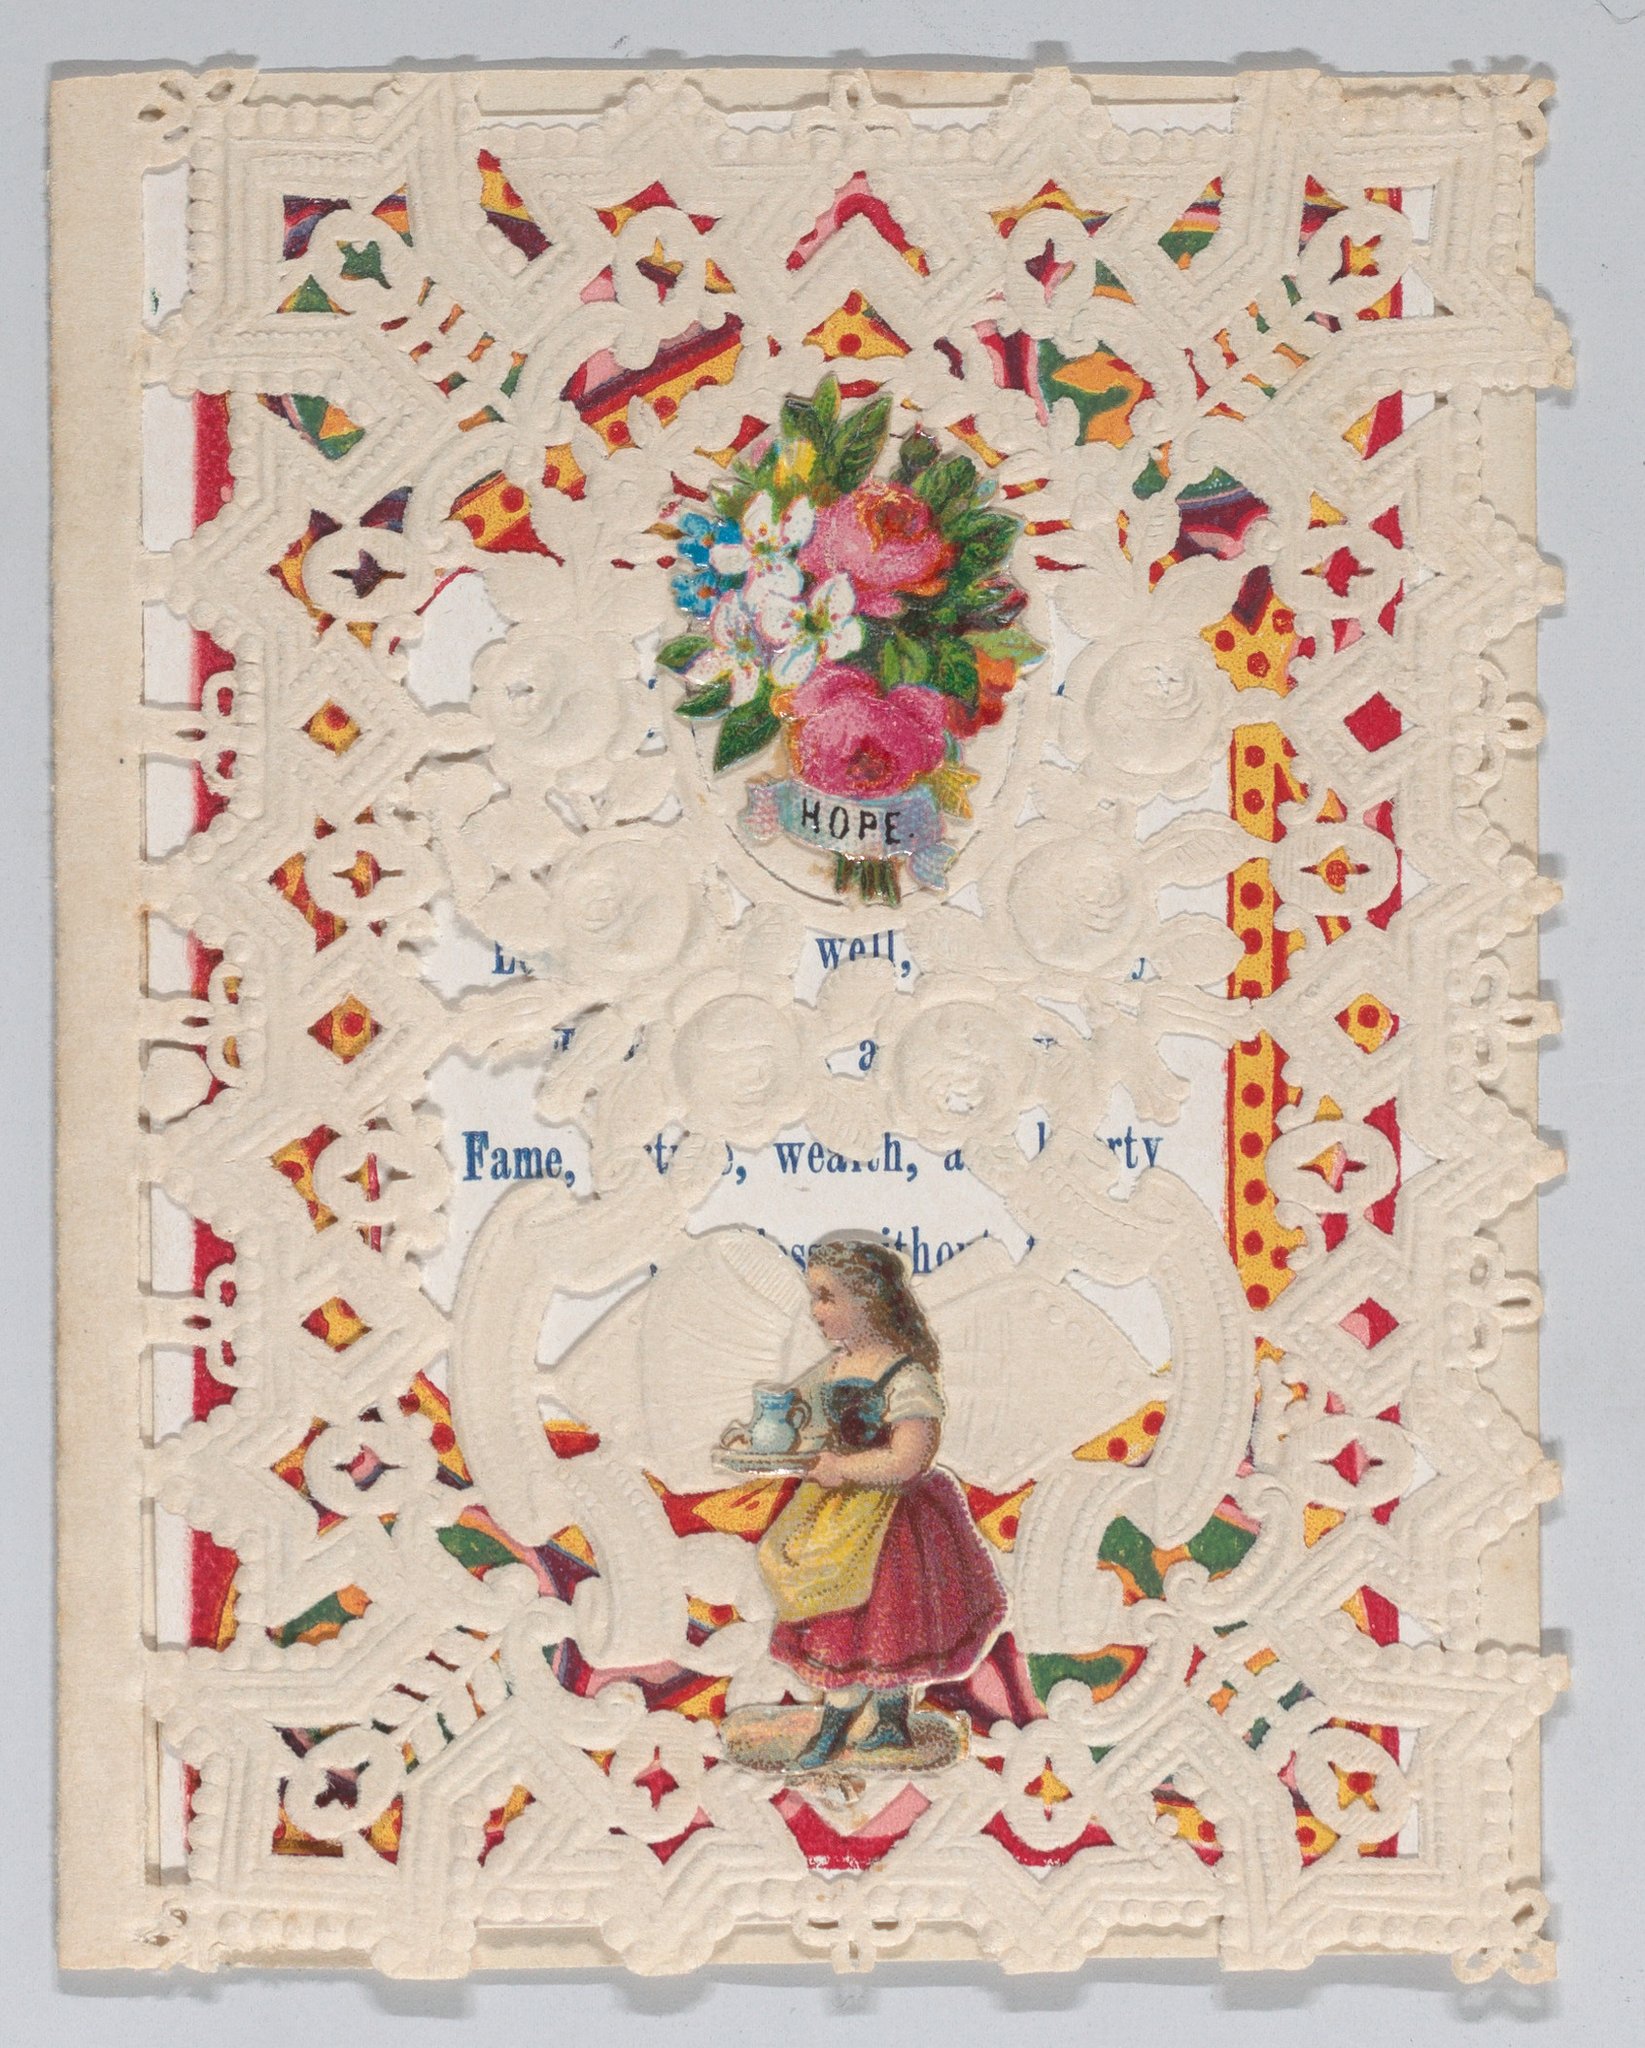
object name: valentine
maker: Anonymous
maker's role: artist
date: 1880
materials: lace, paper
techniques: chromolithography, embossing, open work